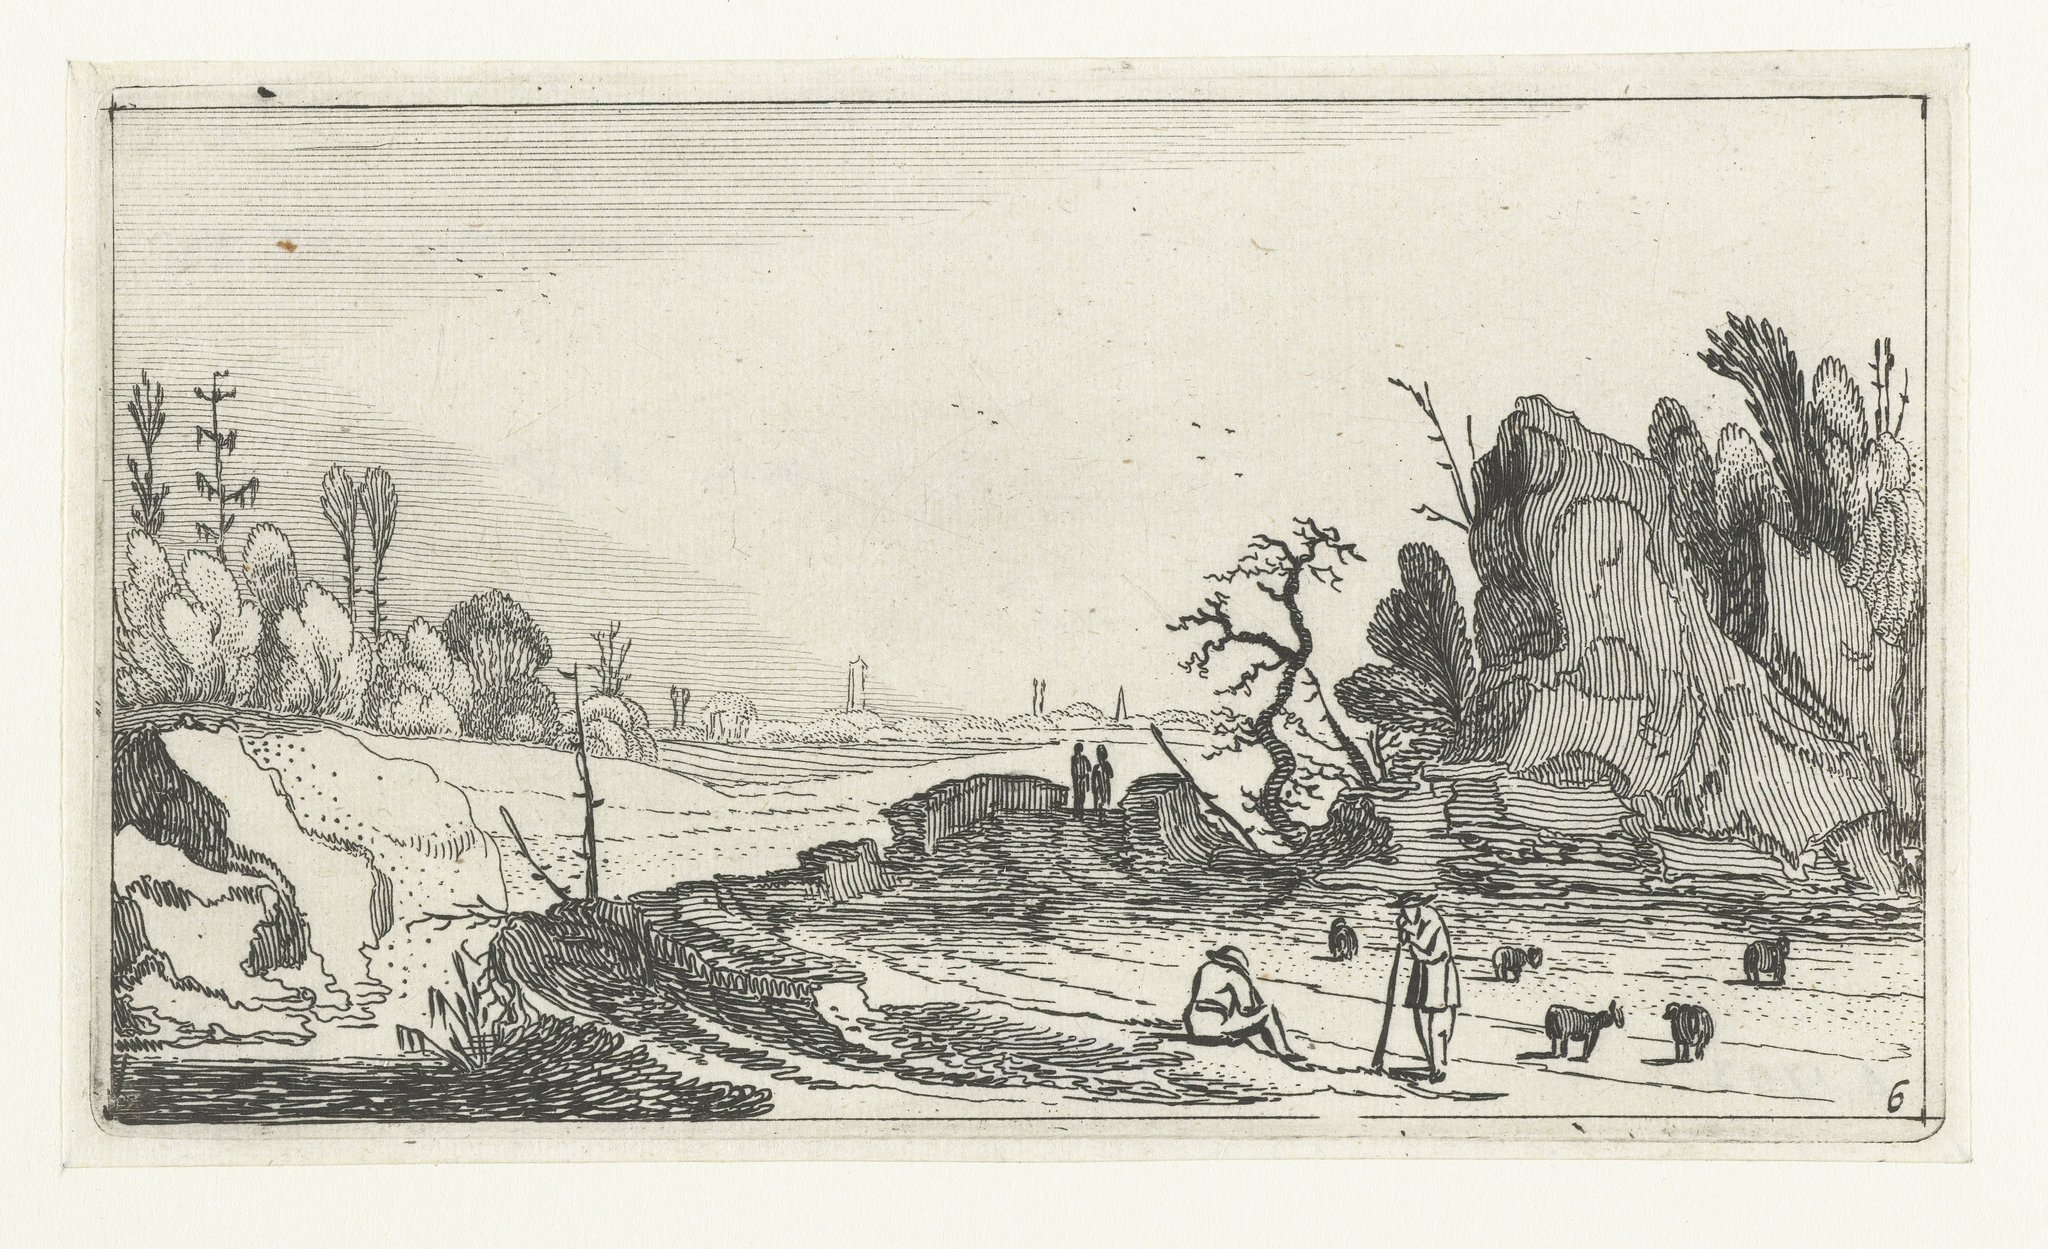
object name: print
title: Landschappen naar Esaias van de Velde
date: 1610-1650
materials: paper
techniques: etching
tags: herding, herdsman, herdswoman, shepherd, shepherdess, cowherd, etc., rocks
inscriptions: collector's mark: Lugt 240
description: Tekening van Esaias van de Velde in Cambridge, Massachusetts, zie Keyes 1984, cat.nr. D 154, pl. 17